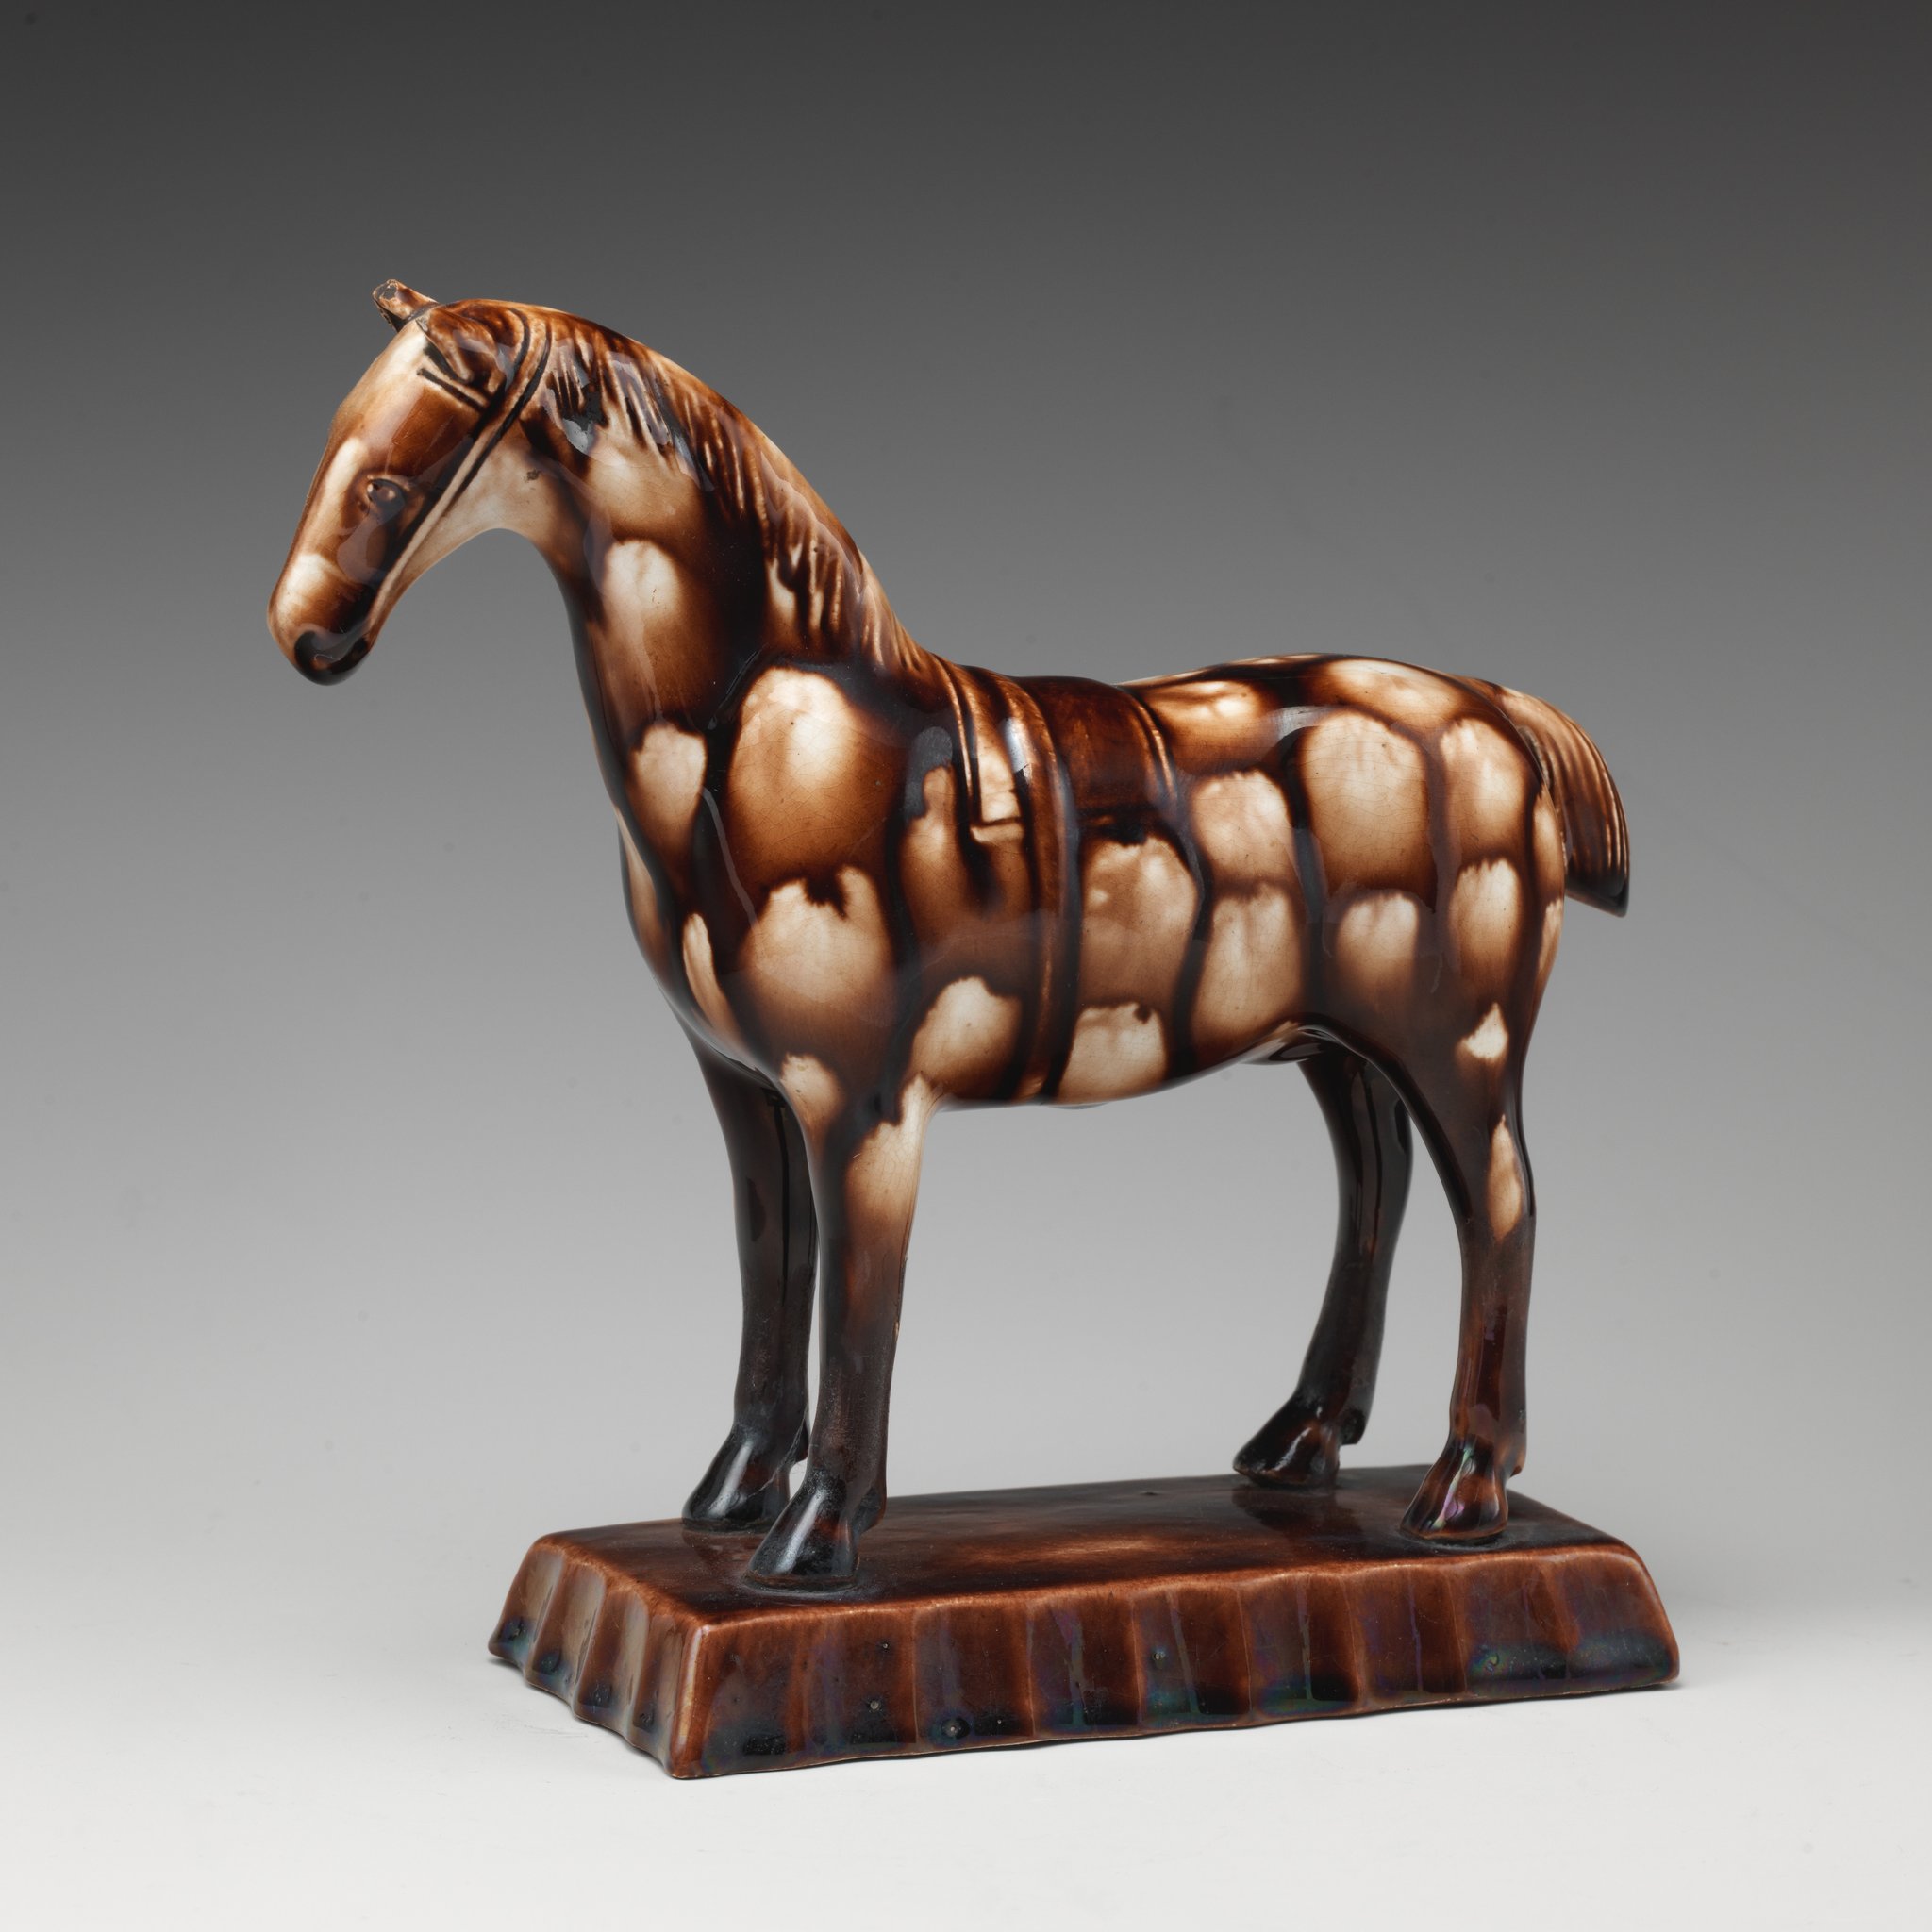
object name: figure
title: Horse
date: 1750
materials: earthenware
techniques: glazing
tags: horses